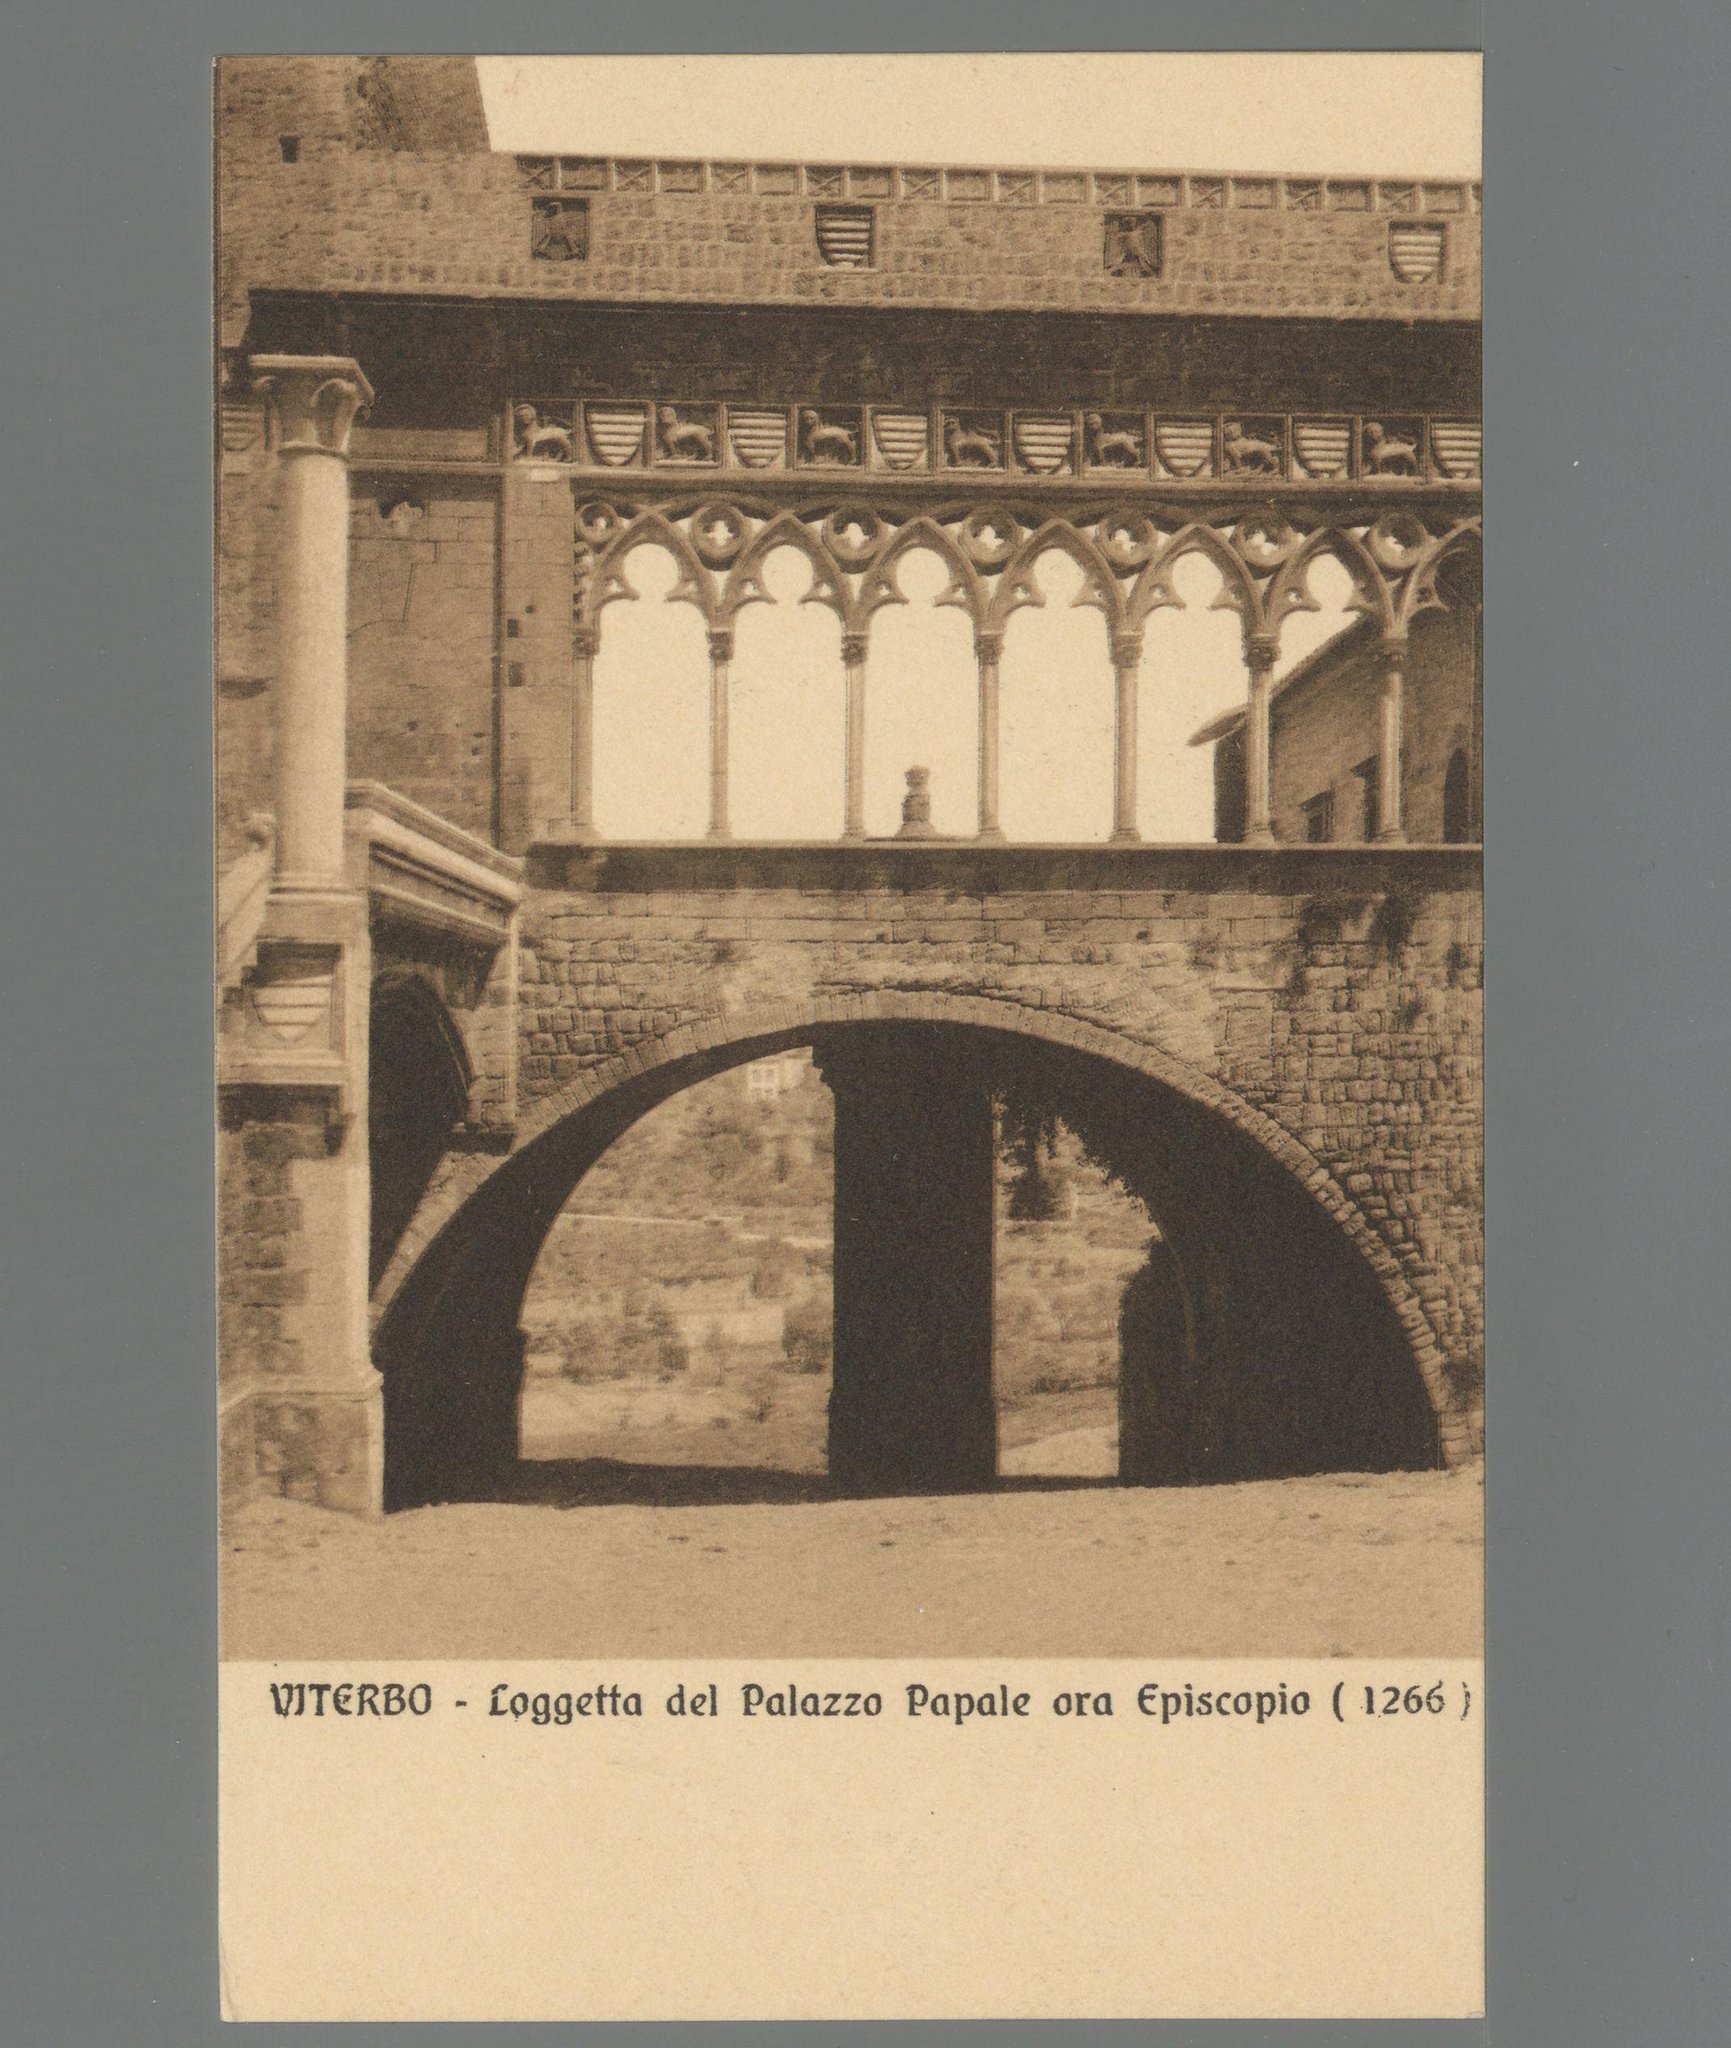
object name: photomechanical print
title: Viterbo. Loggetta del Palazzo Papale ora Episcopio (1266)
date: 1908-1914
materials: cardboard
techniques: photograph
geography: italy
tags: palace, loggia, verandah, porch